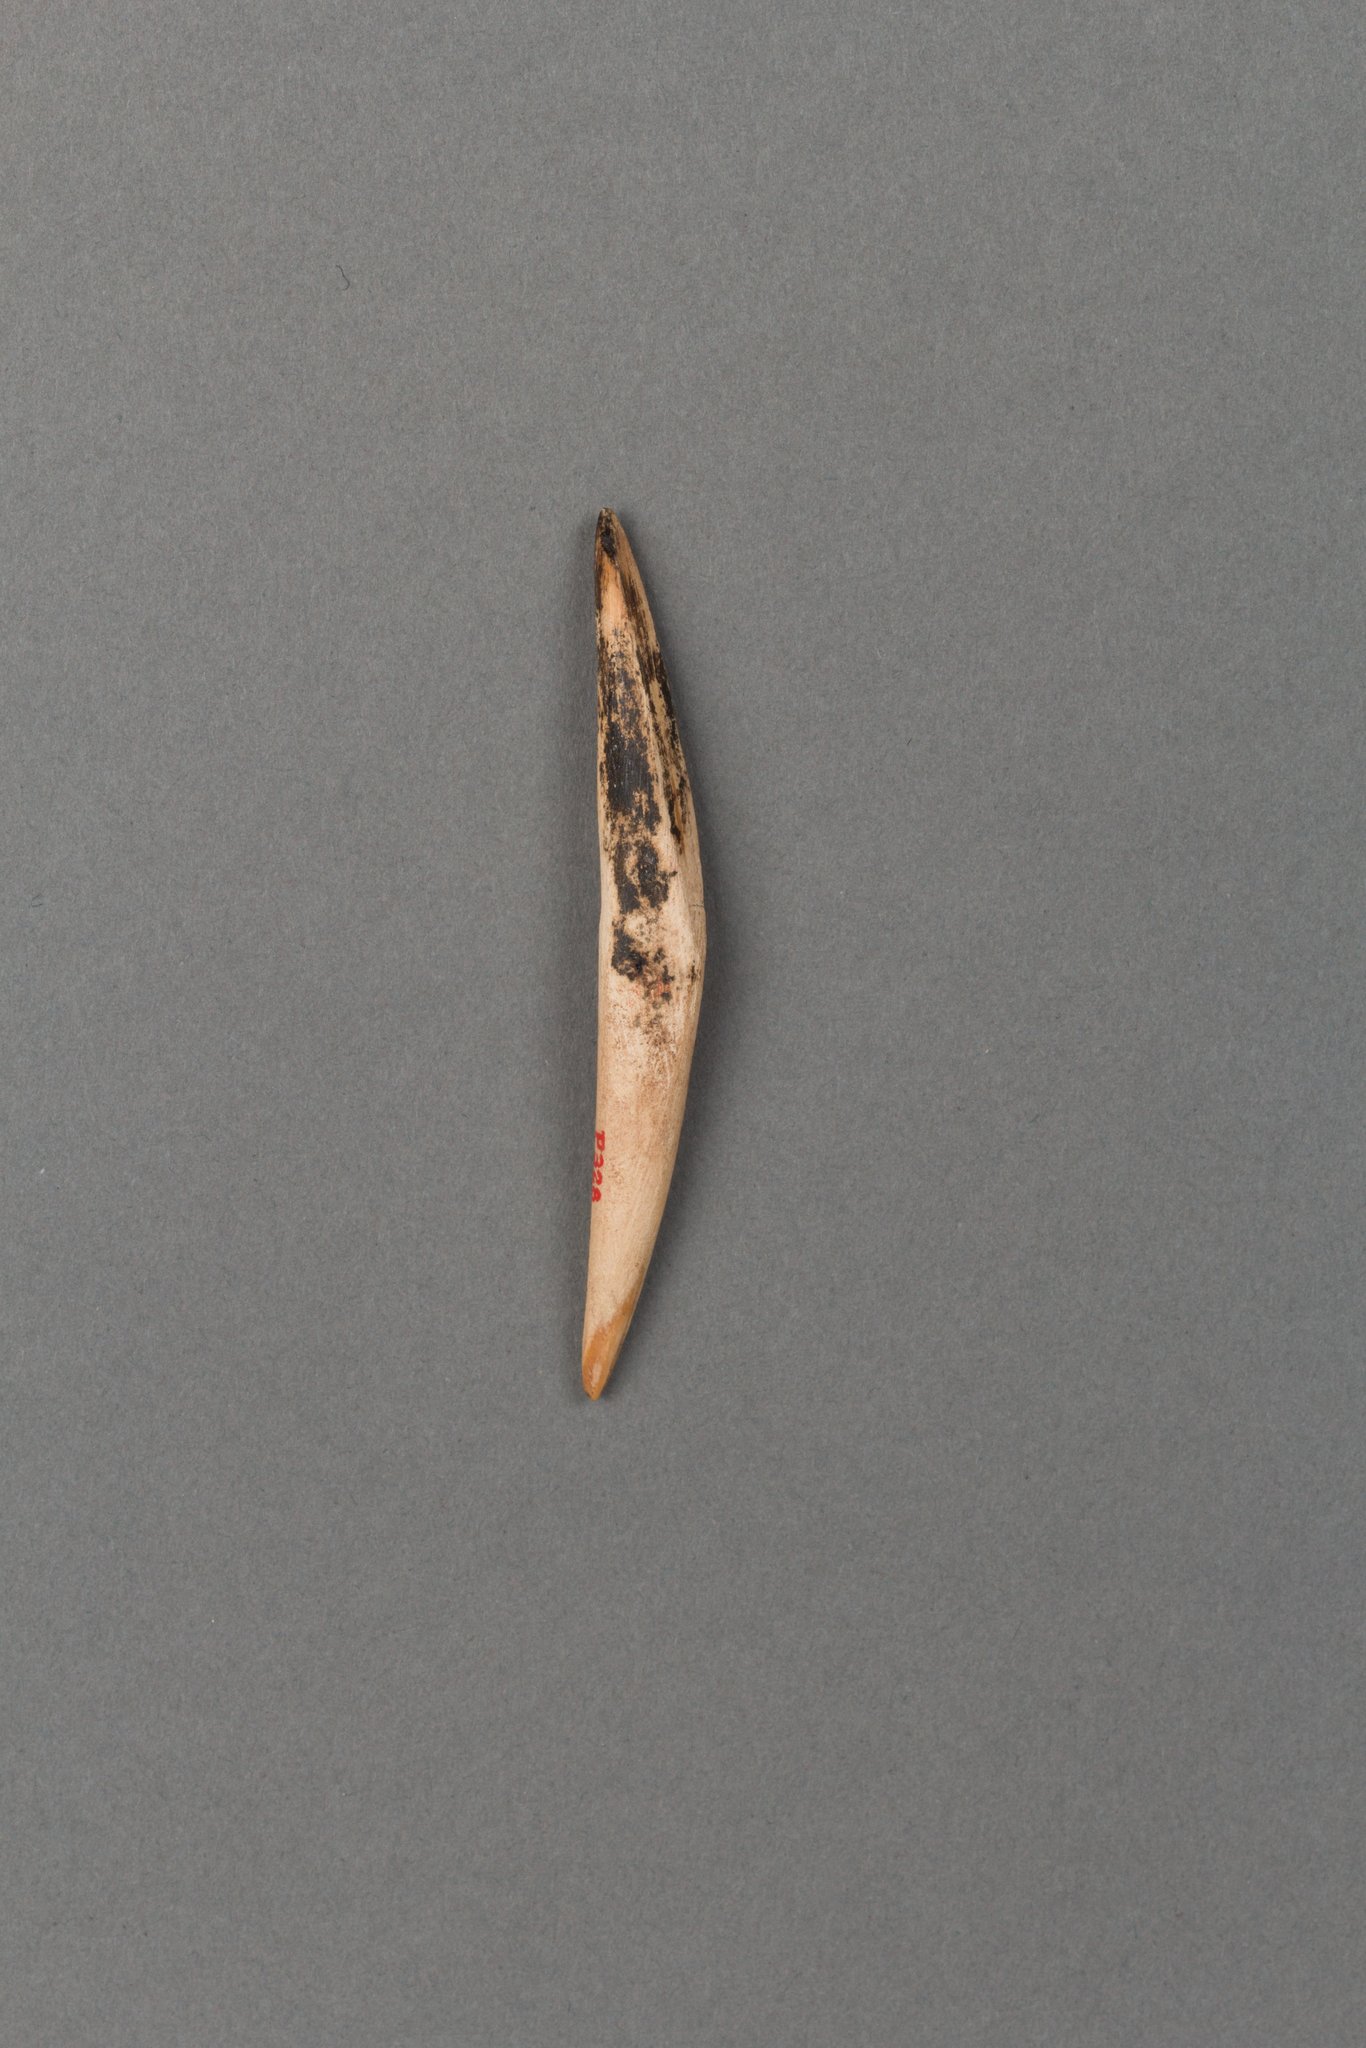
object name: body ornament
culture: japanese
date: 1200-200 BCE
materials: bone